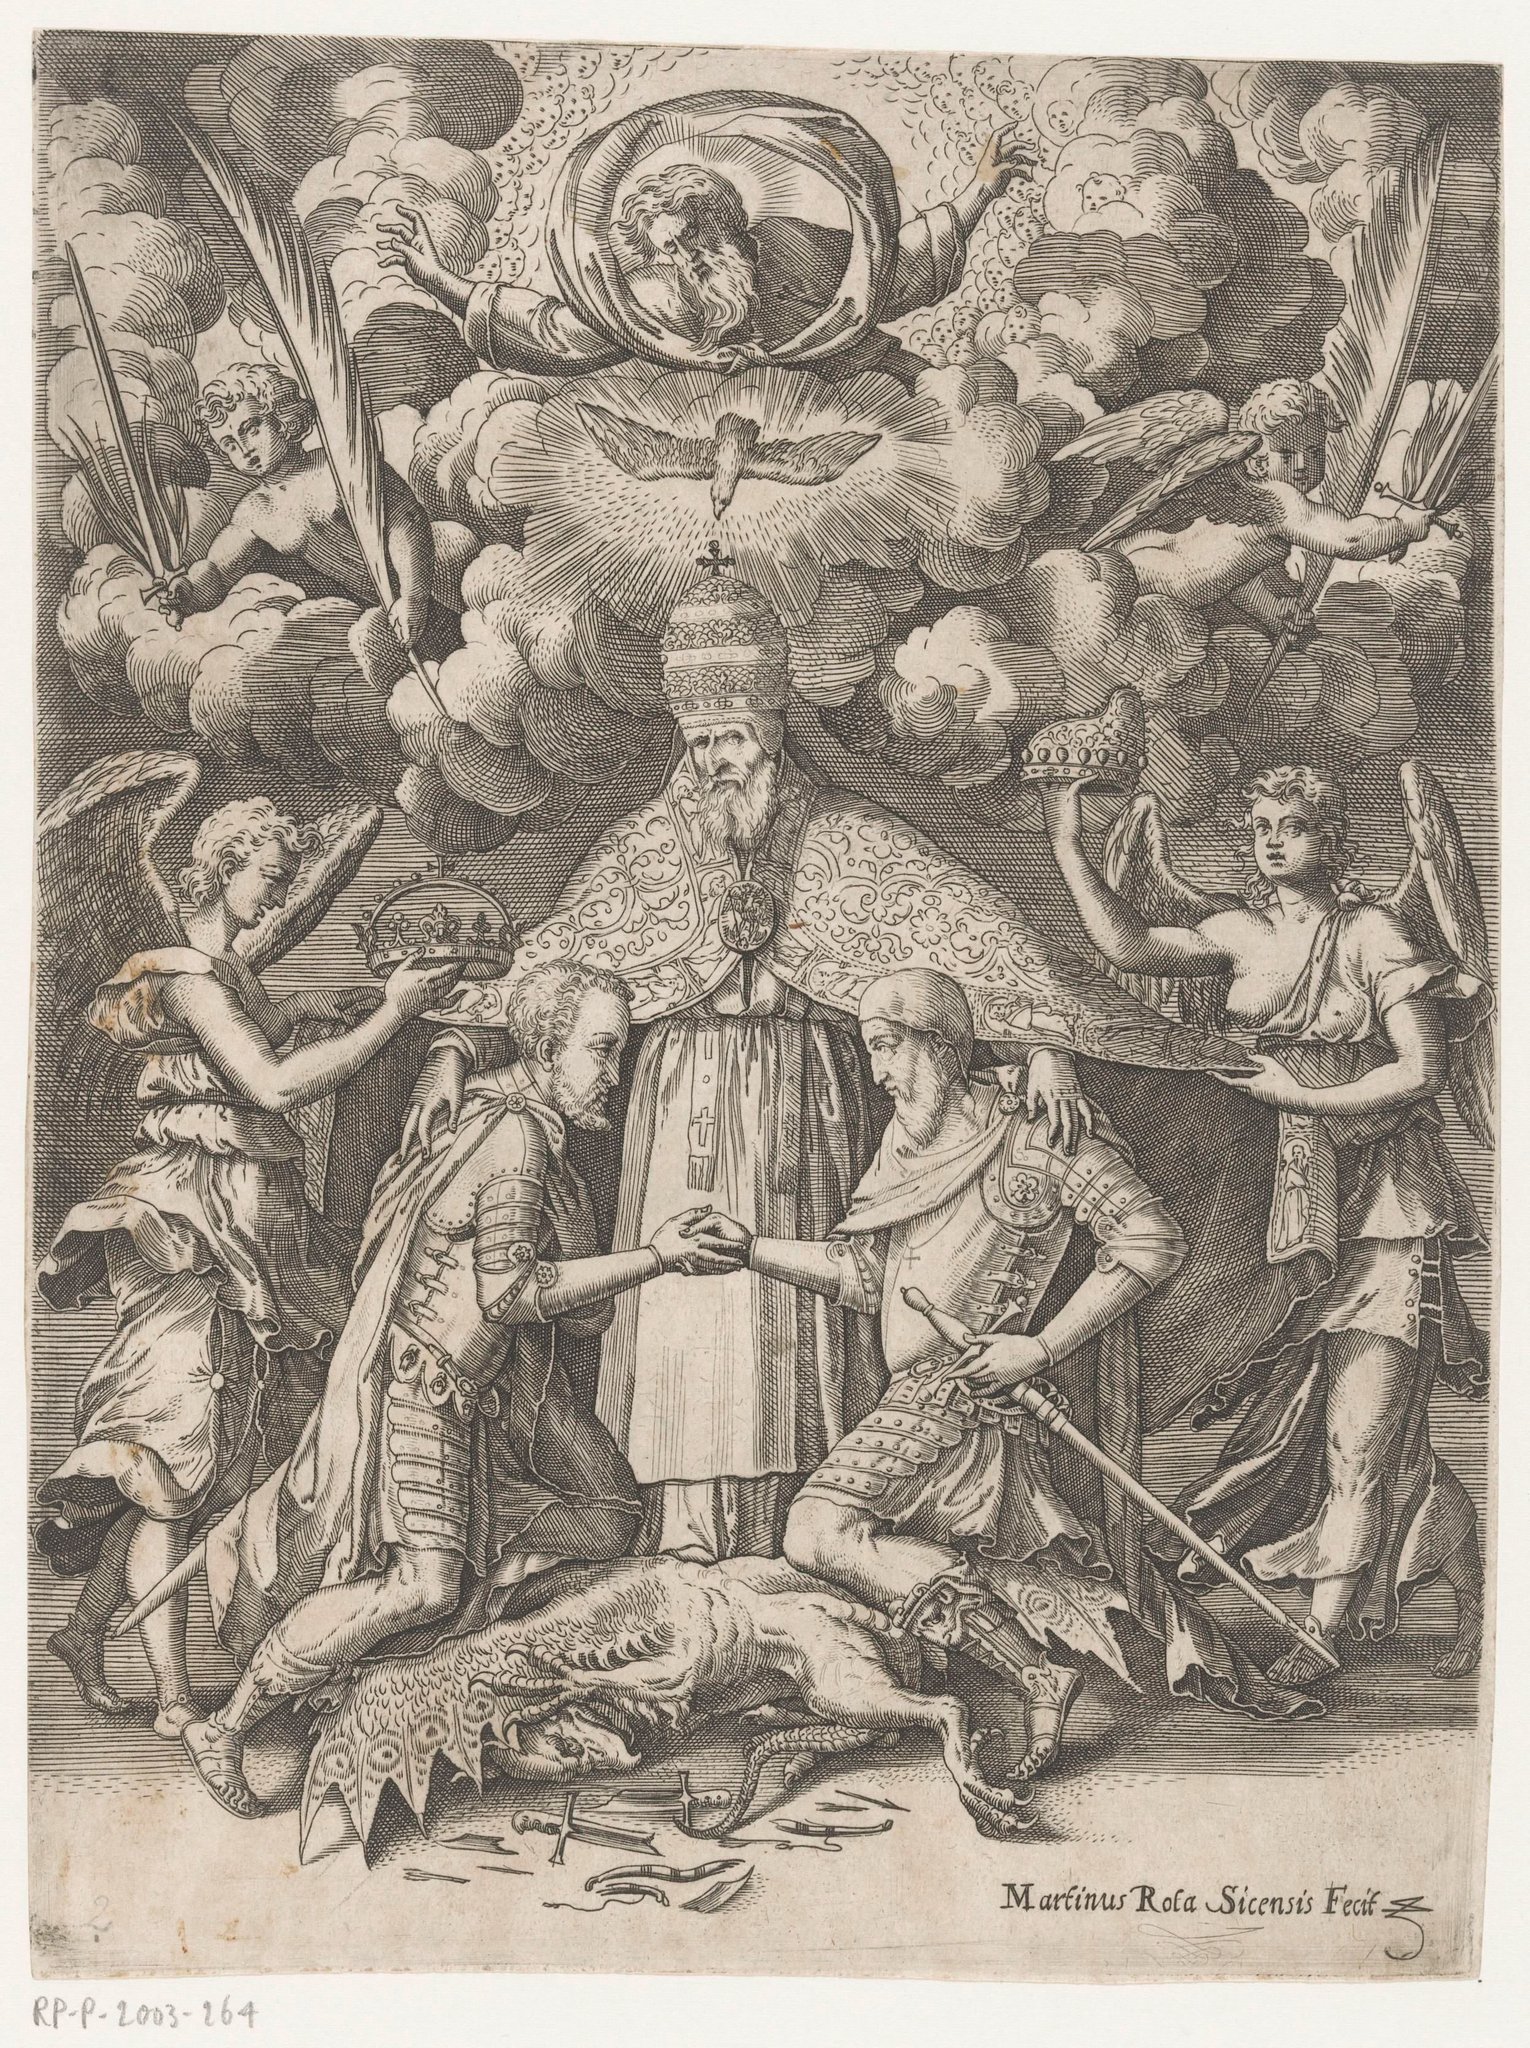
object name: print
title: Paus Pius V allieert zich met Filips II, koning van Spanje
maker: martino rota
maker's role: print maker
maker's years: 1520-1583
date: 1566-1572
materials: paper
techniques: engraving, etching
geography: italy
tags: philip ii of spain, rome, pius v, god the father, ruler, sovereign, other sovereign: doge, pope, angels, holy ghost represented as a dove (in flames)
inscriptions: collector's mark: Lugt 2228, collector's mark: Lugt 2760